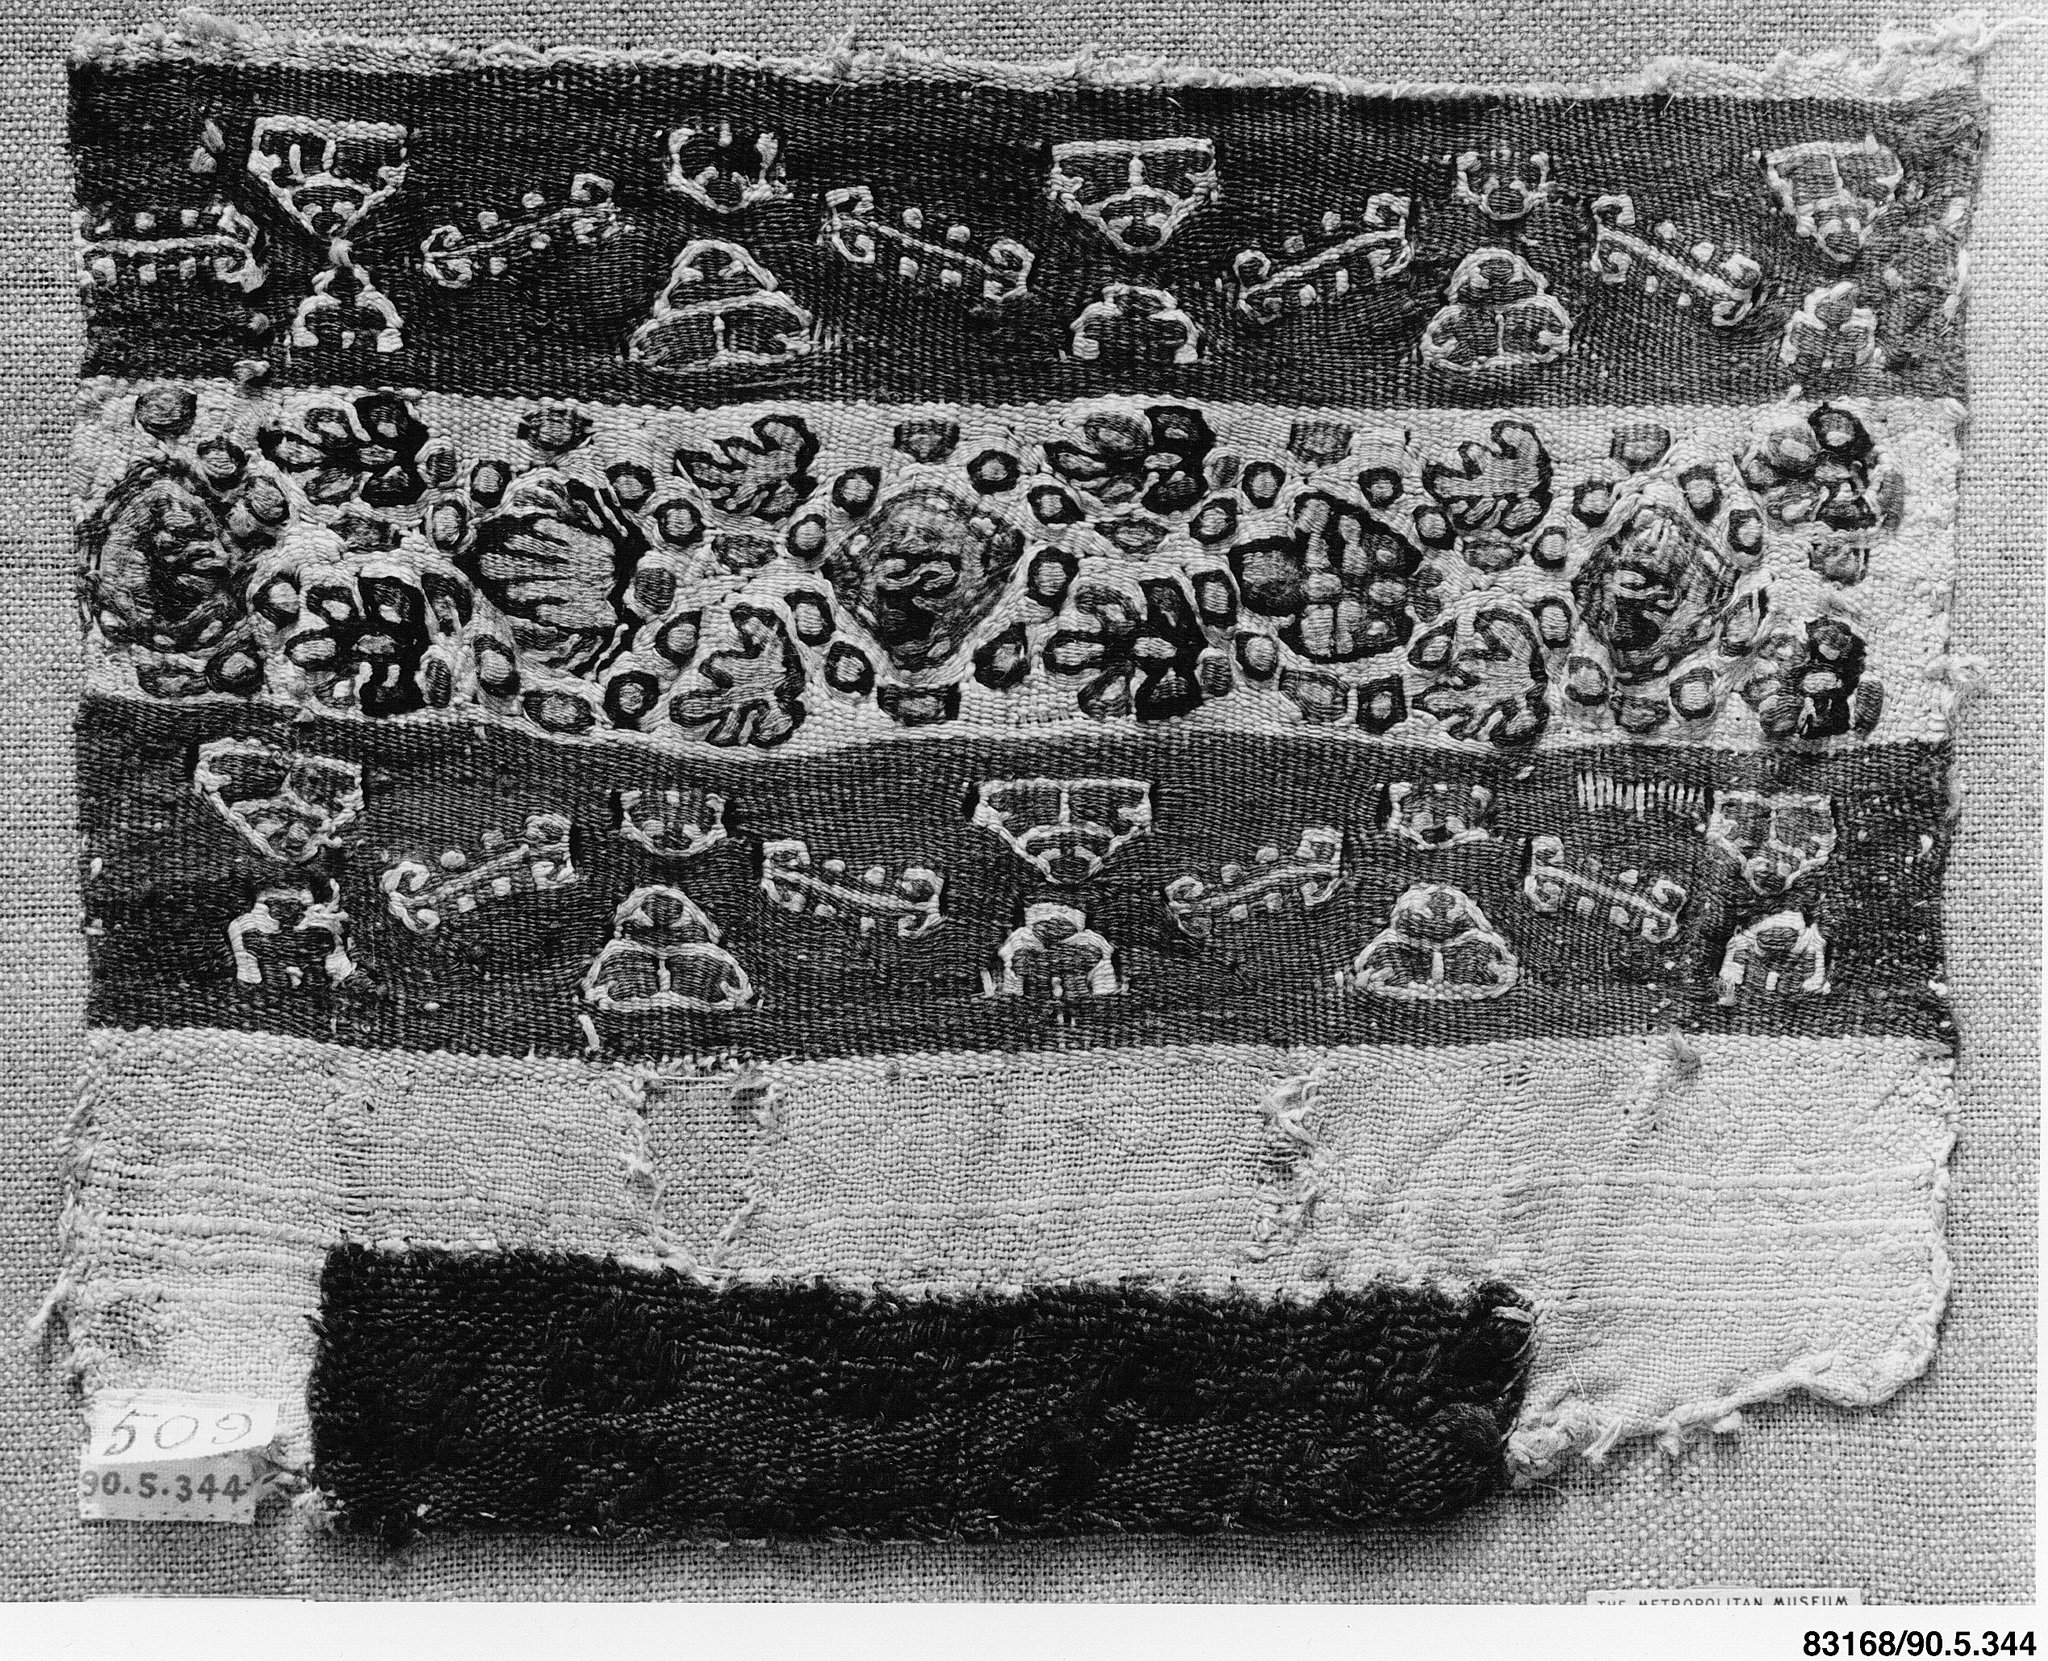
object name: textile fragment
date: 401-600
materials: linen, wool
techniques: weave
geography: egypt